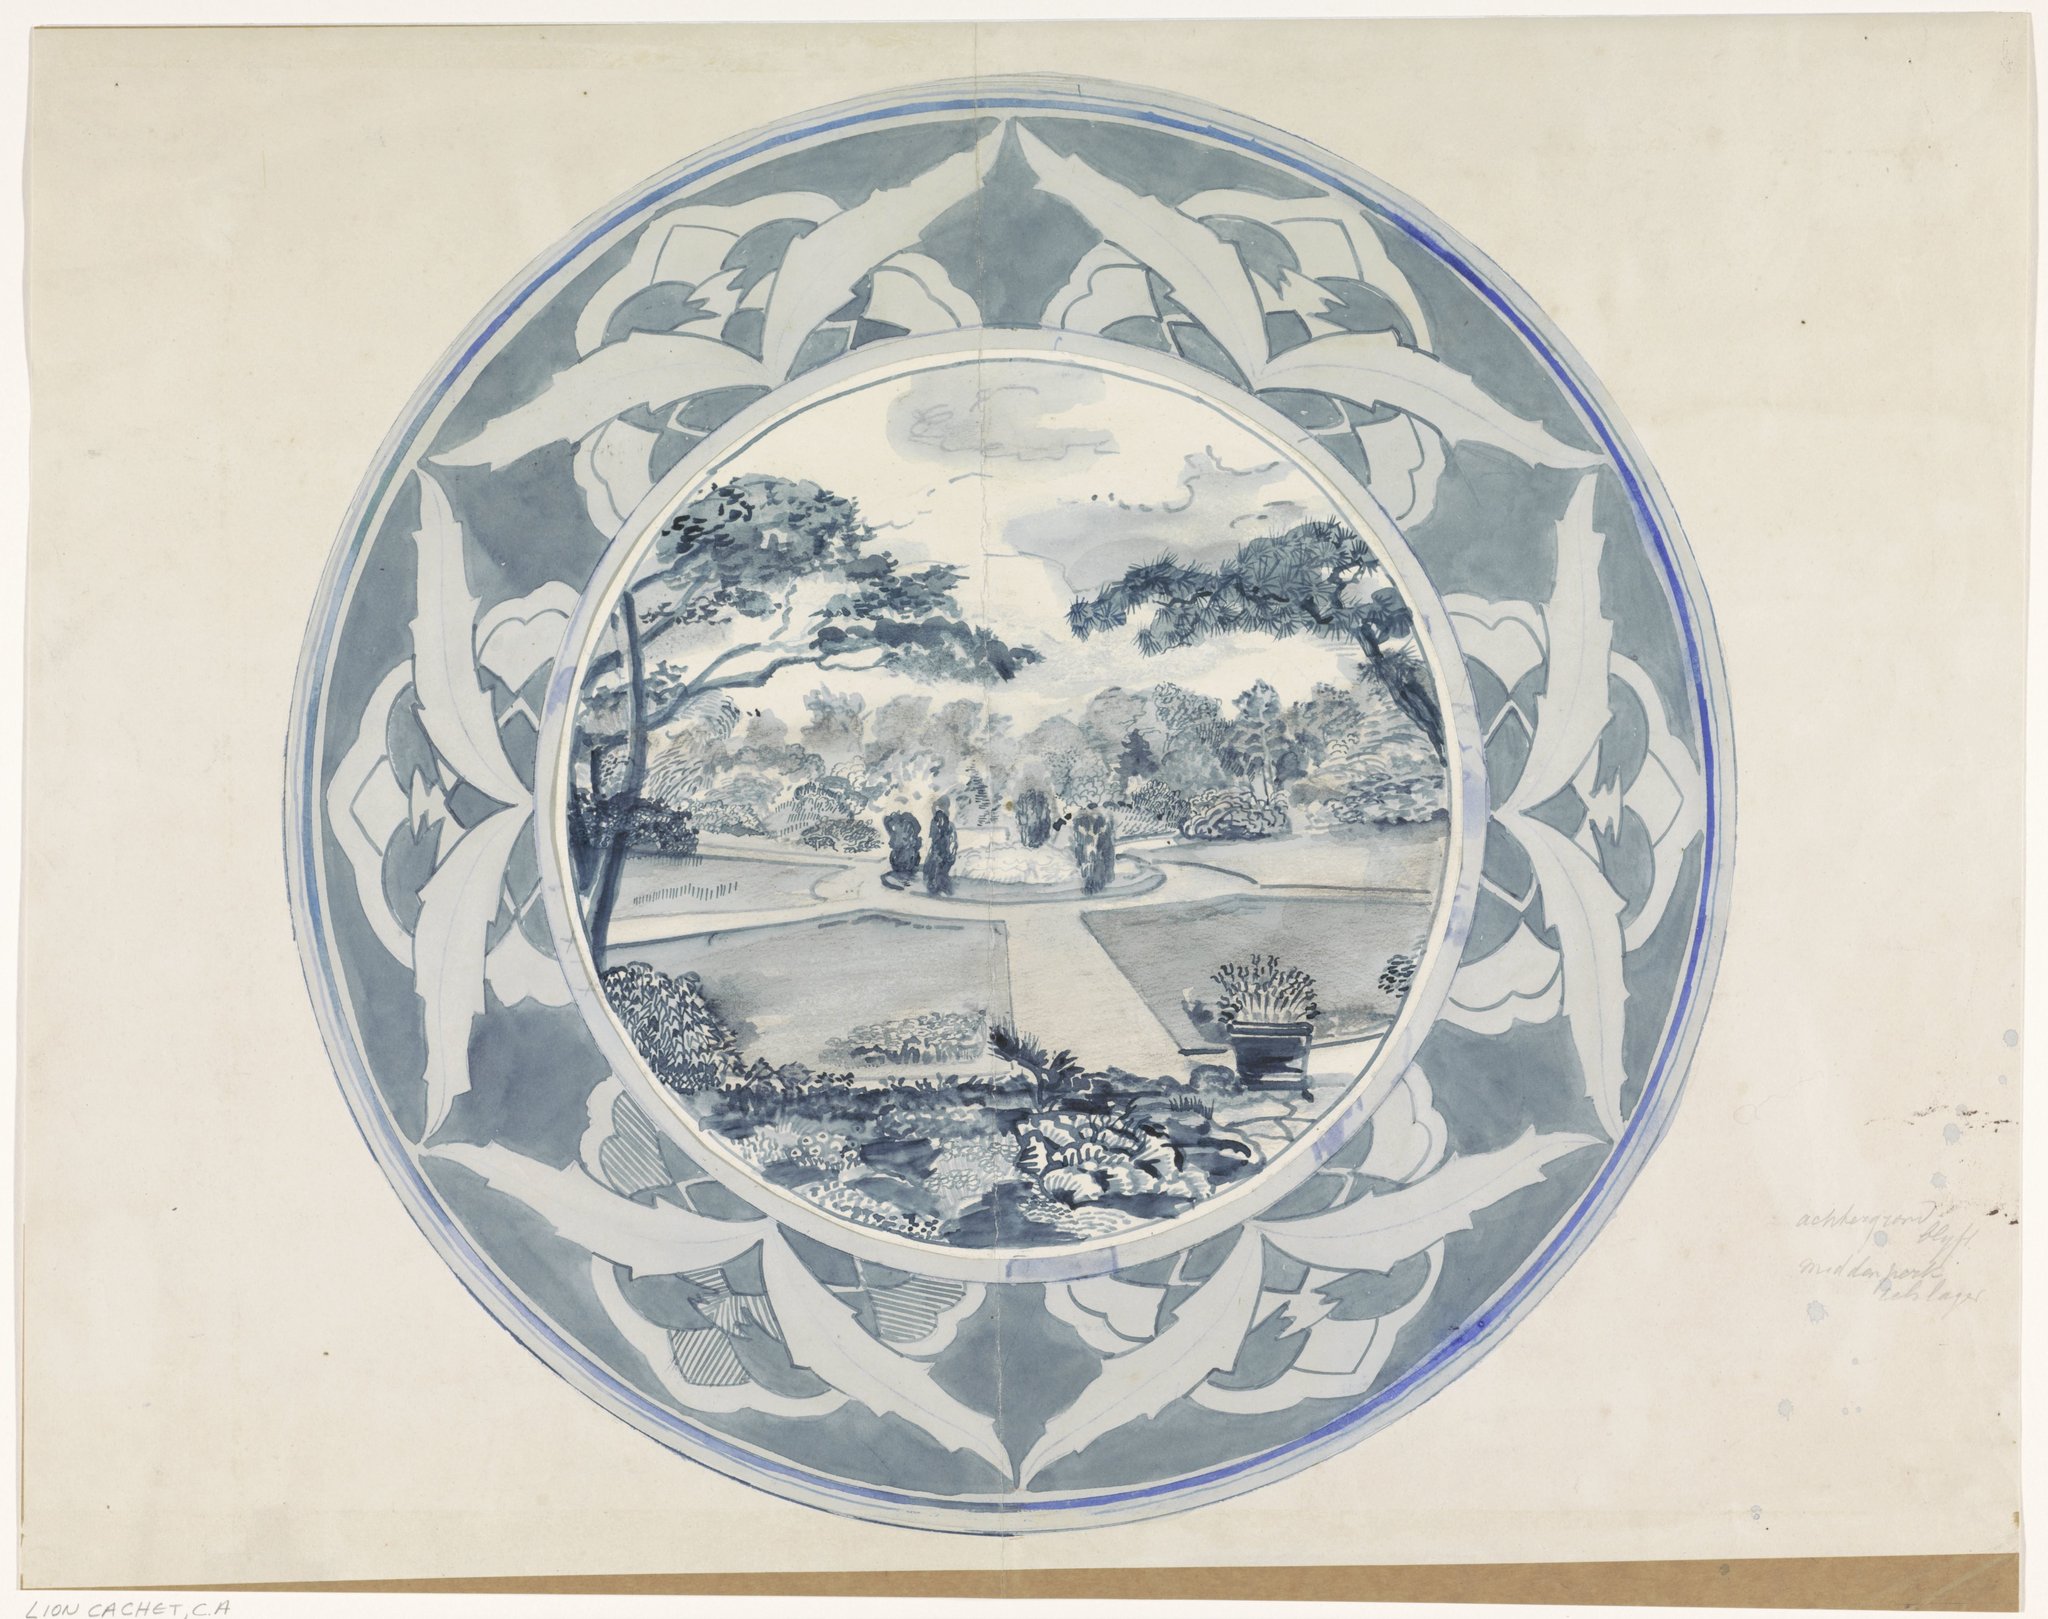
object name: drawing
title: Ontwerp voor een bord met een tuingezicht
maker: carel adolph lion cachet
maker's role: draughtsman, print maker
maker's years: 1864-1945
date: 1874-1945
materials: paper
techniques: brush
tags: dish, plate, saucer